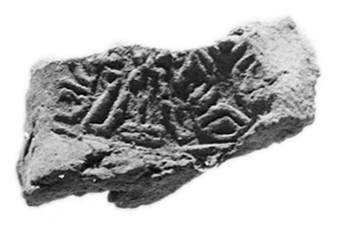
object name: sealing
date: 1981-1640 BCE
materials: mud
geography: egypt